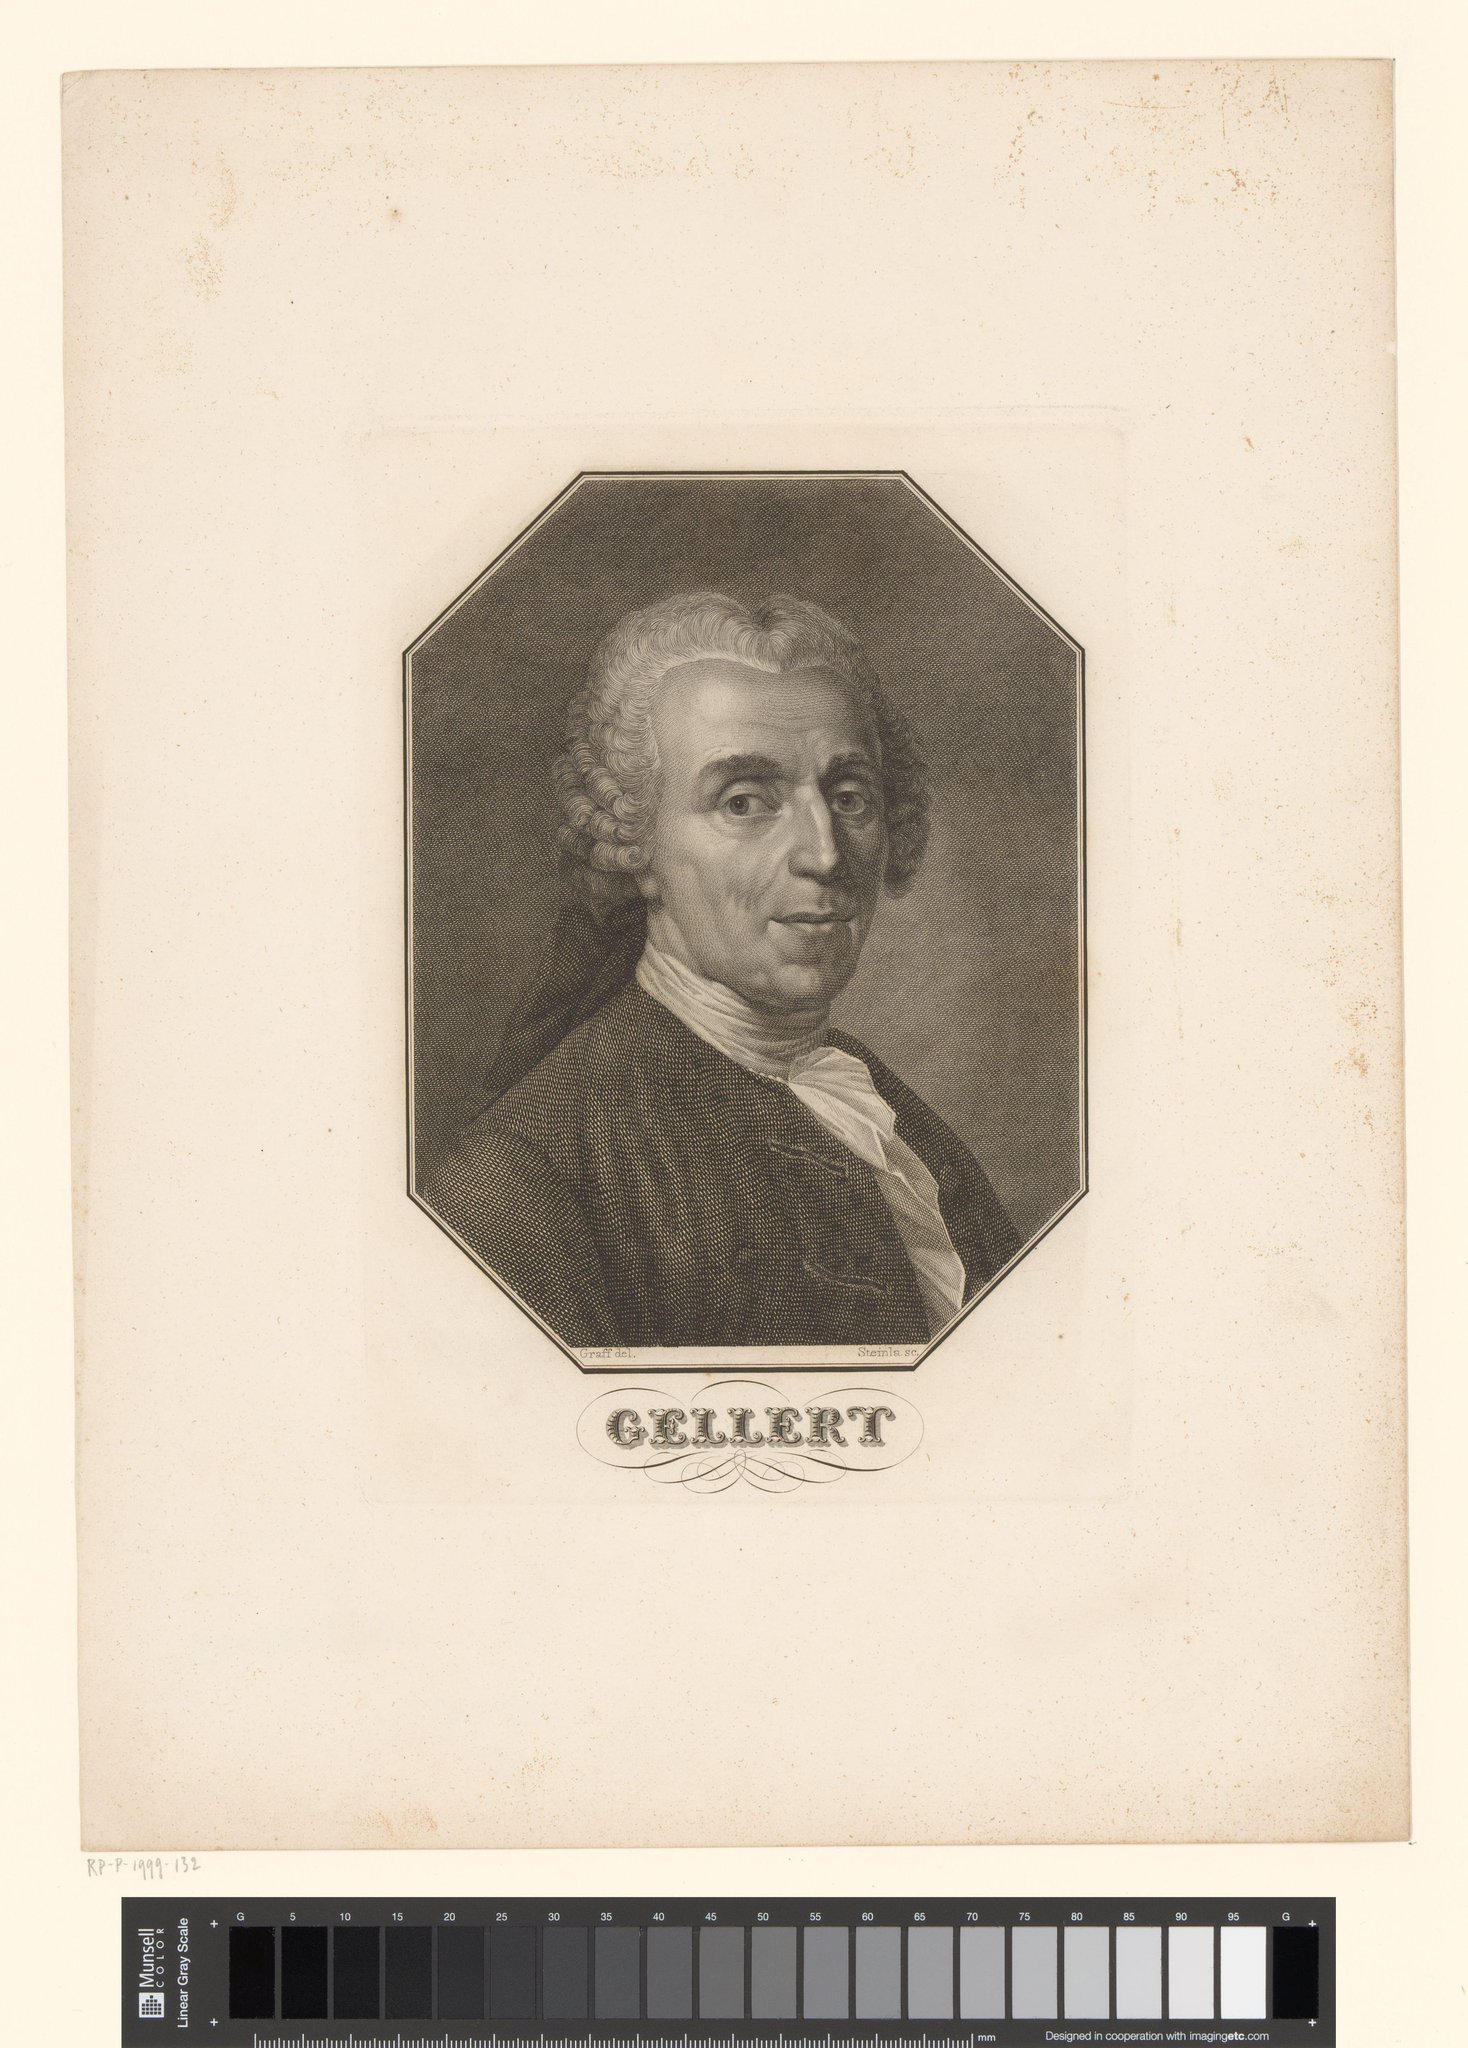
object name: print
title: Portret van Christian Fürchtegott Gellert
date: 1801-1858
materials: paper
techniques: engraving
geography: germany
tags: historical persons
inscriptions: collector's mark: Lugt 2760, collector's mark: Lugt 2228